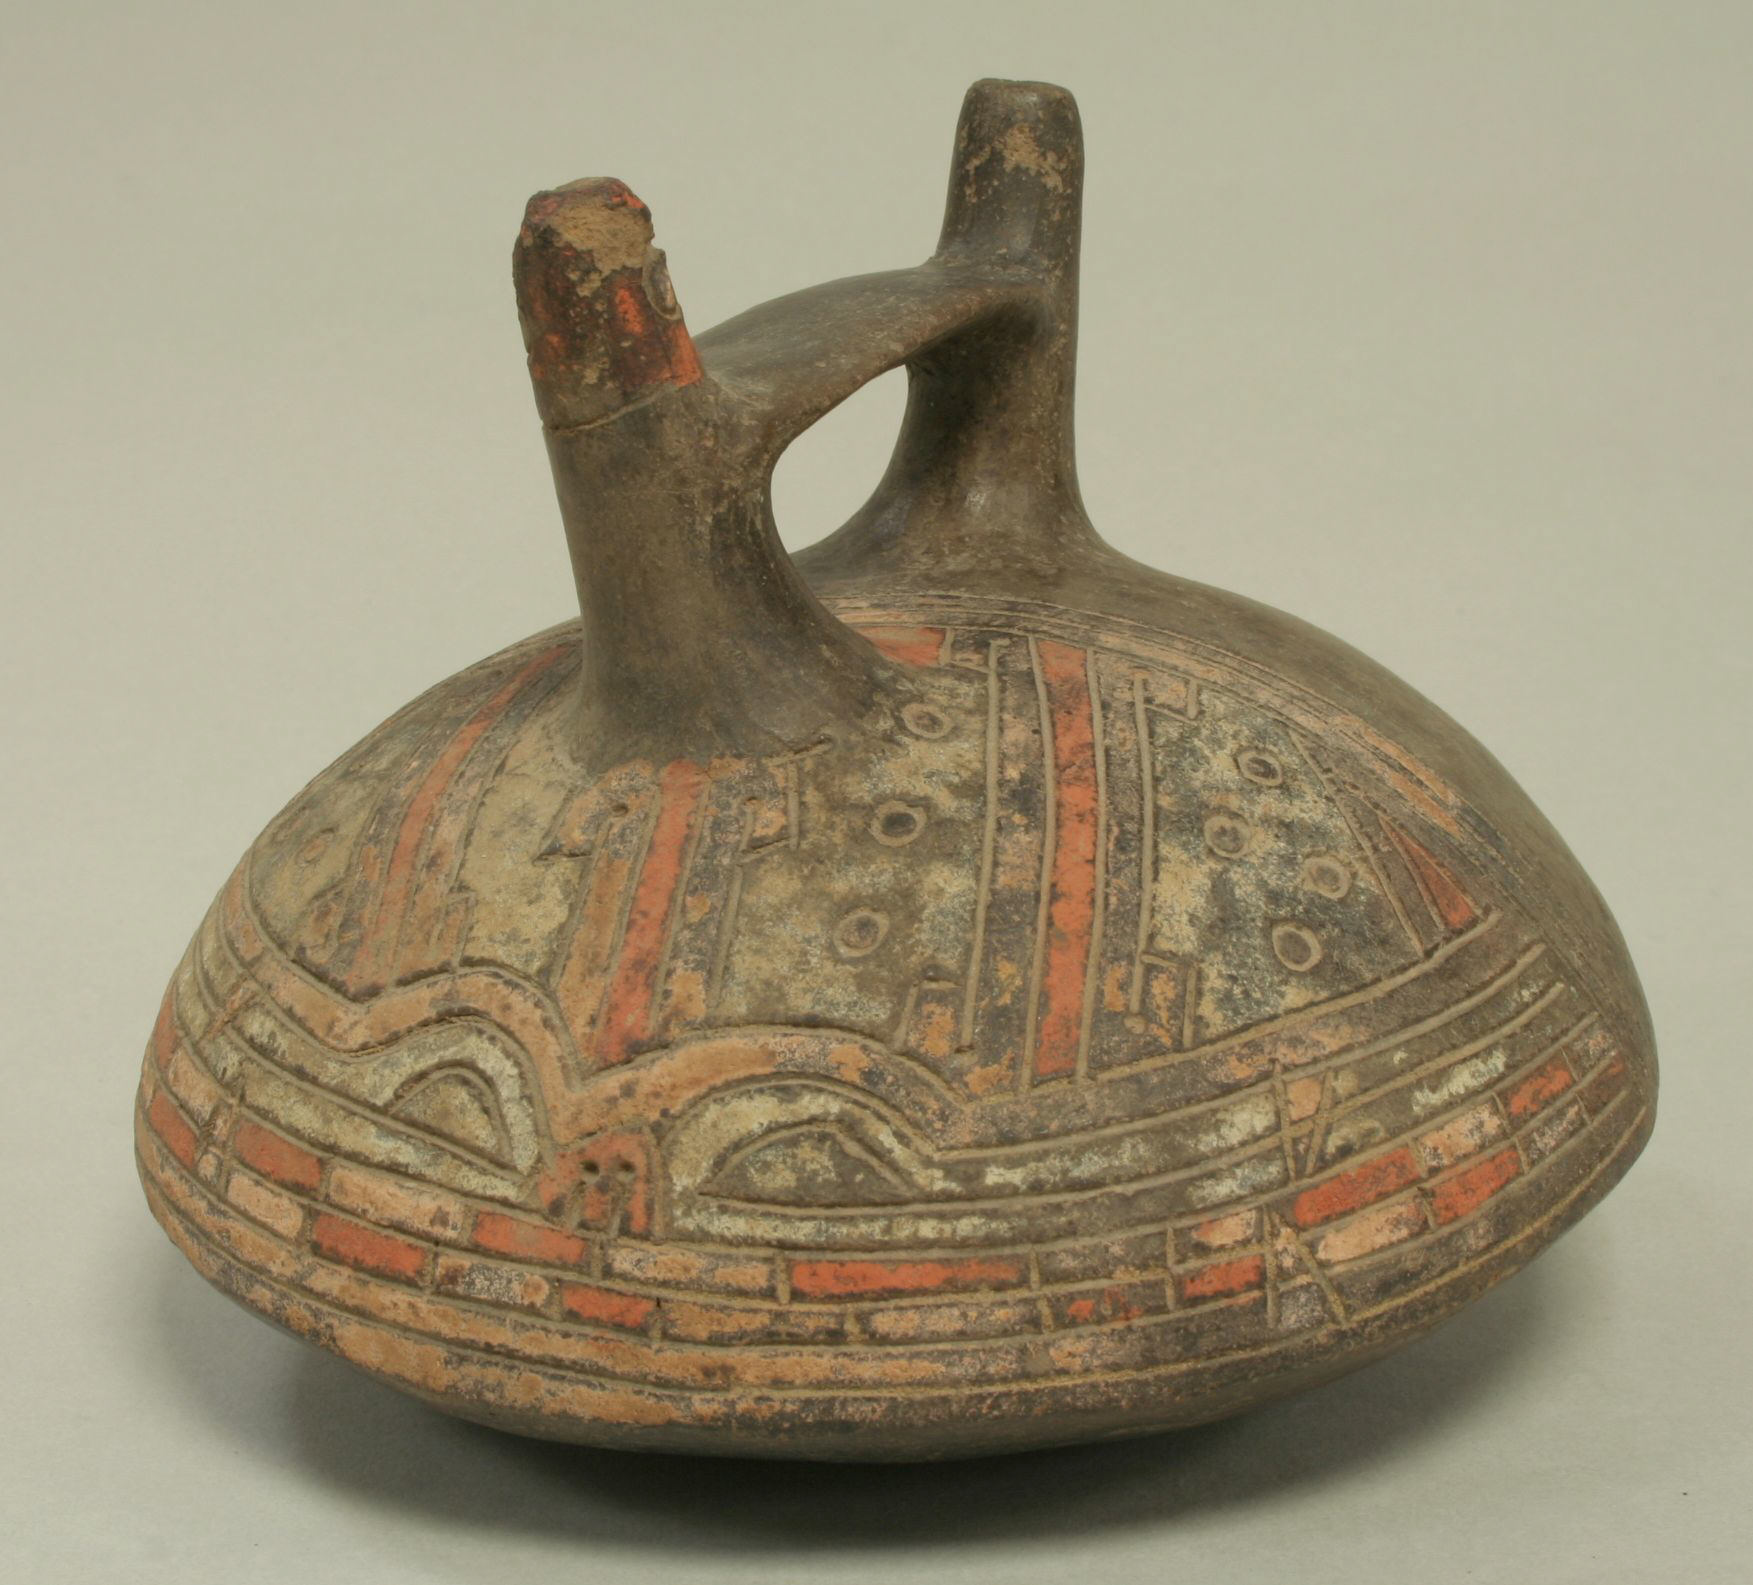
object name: bottle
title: Double Spout and Bridge Bottle with Feline Face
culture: paracas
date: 300-101 BCE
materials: ceramic, pigment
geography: peru